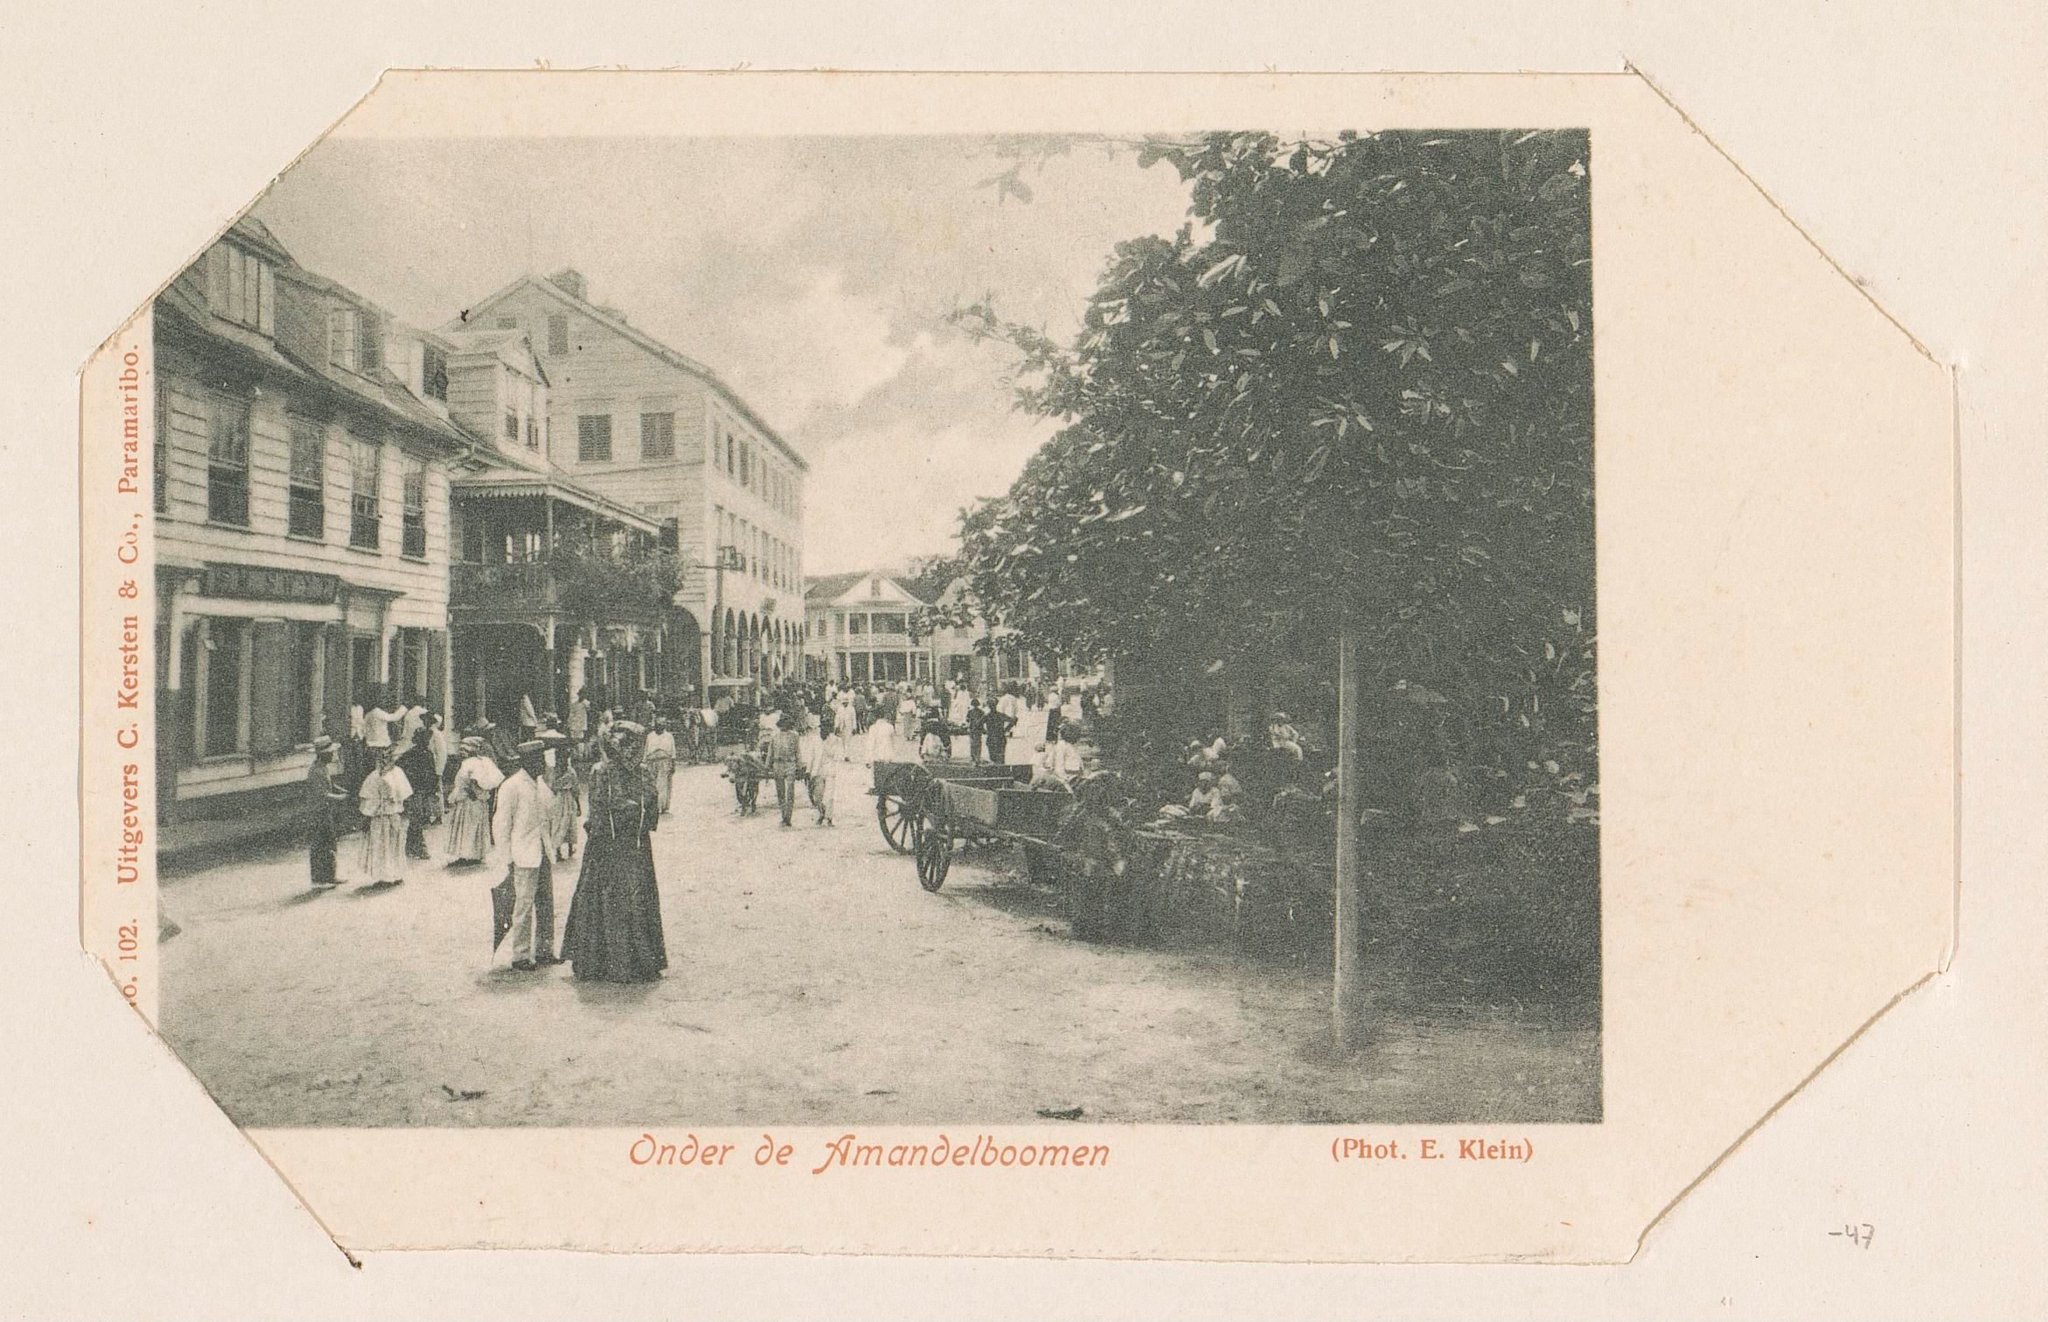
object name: ansichtkaart, prentbriefkaart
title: Onder de Amandelboomen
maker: eugen klein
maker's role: fotograaf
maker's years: 1869-1927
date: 1900-1910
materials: cardboard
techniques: photograph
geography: paramaribo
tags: street (+ city(-scape) with figures, staffage)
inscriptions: serial number: ‘No. 102. Uitgevers C. Kersten & Co., Paramaribo’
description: Straatgezicht te Paramaribo, rechts zitten mensen in de schaduw van een groep amandelbomen. Waarschijnlijk de Waterkant. Onderdeel van een verzameling van 68 briefkaarten uit Suriname, bijeengebracht in een album als aandenken aan een verblijf in Suriname in september 1911.